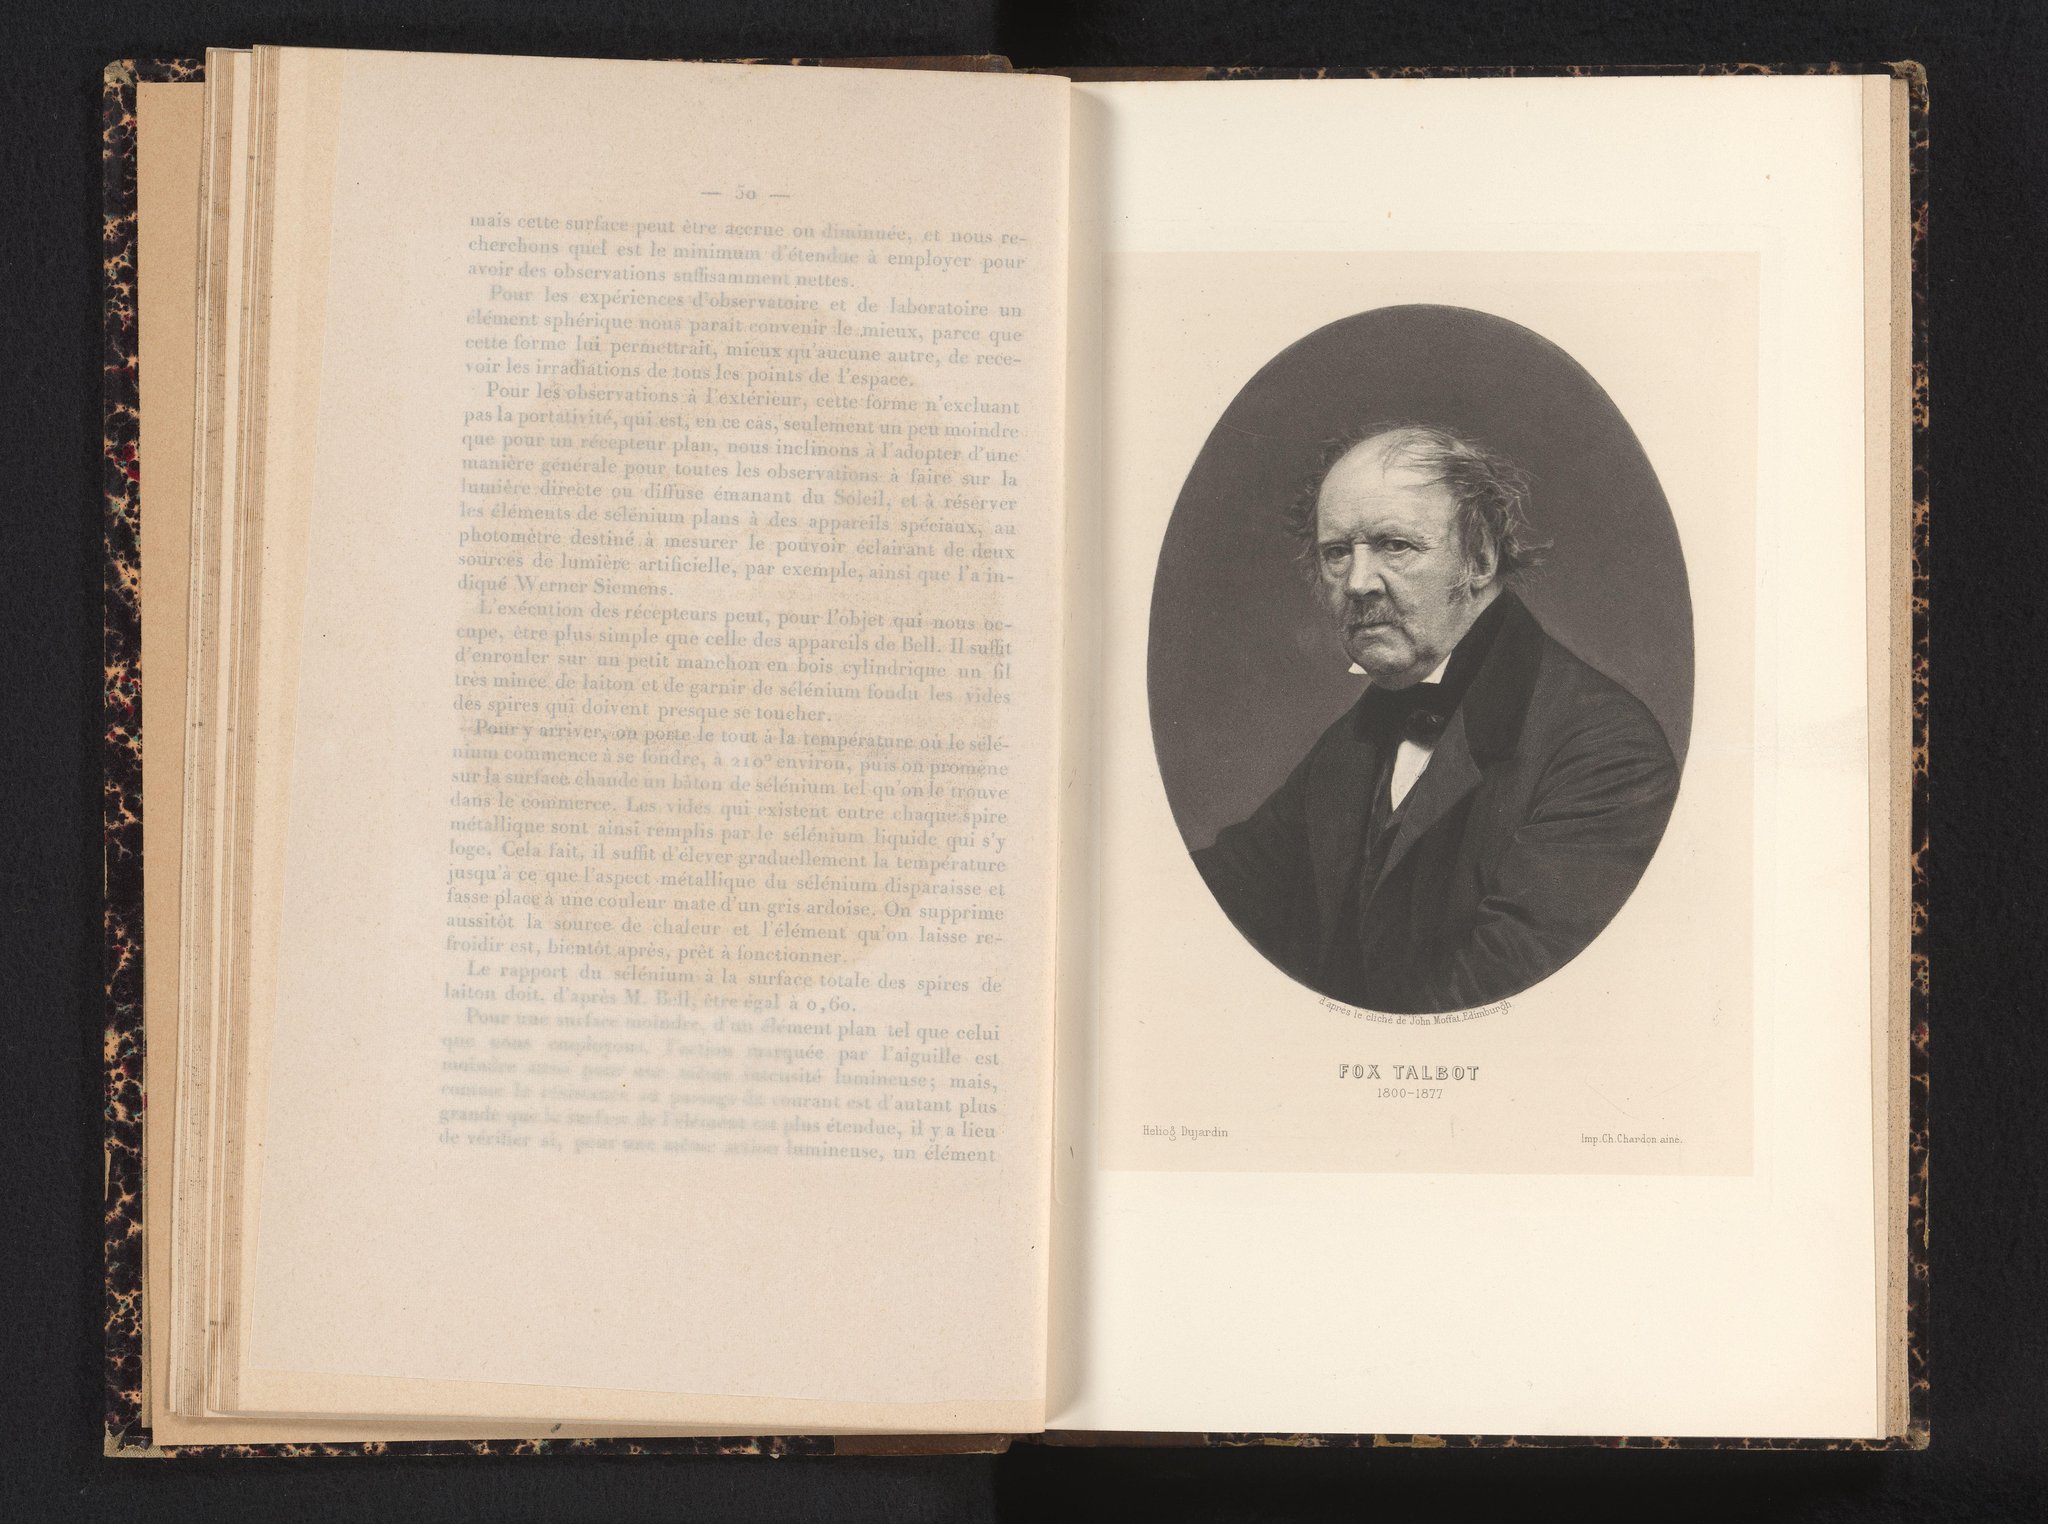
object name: page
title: Portret van William Henry Fox Talbot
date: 1872-1877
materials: paper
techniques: photoaquatint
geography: paris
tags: william henry fox talbot, historical persons, portrait, self-portrait of photographer